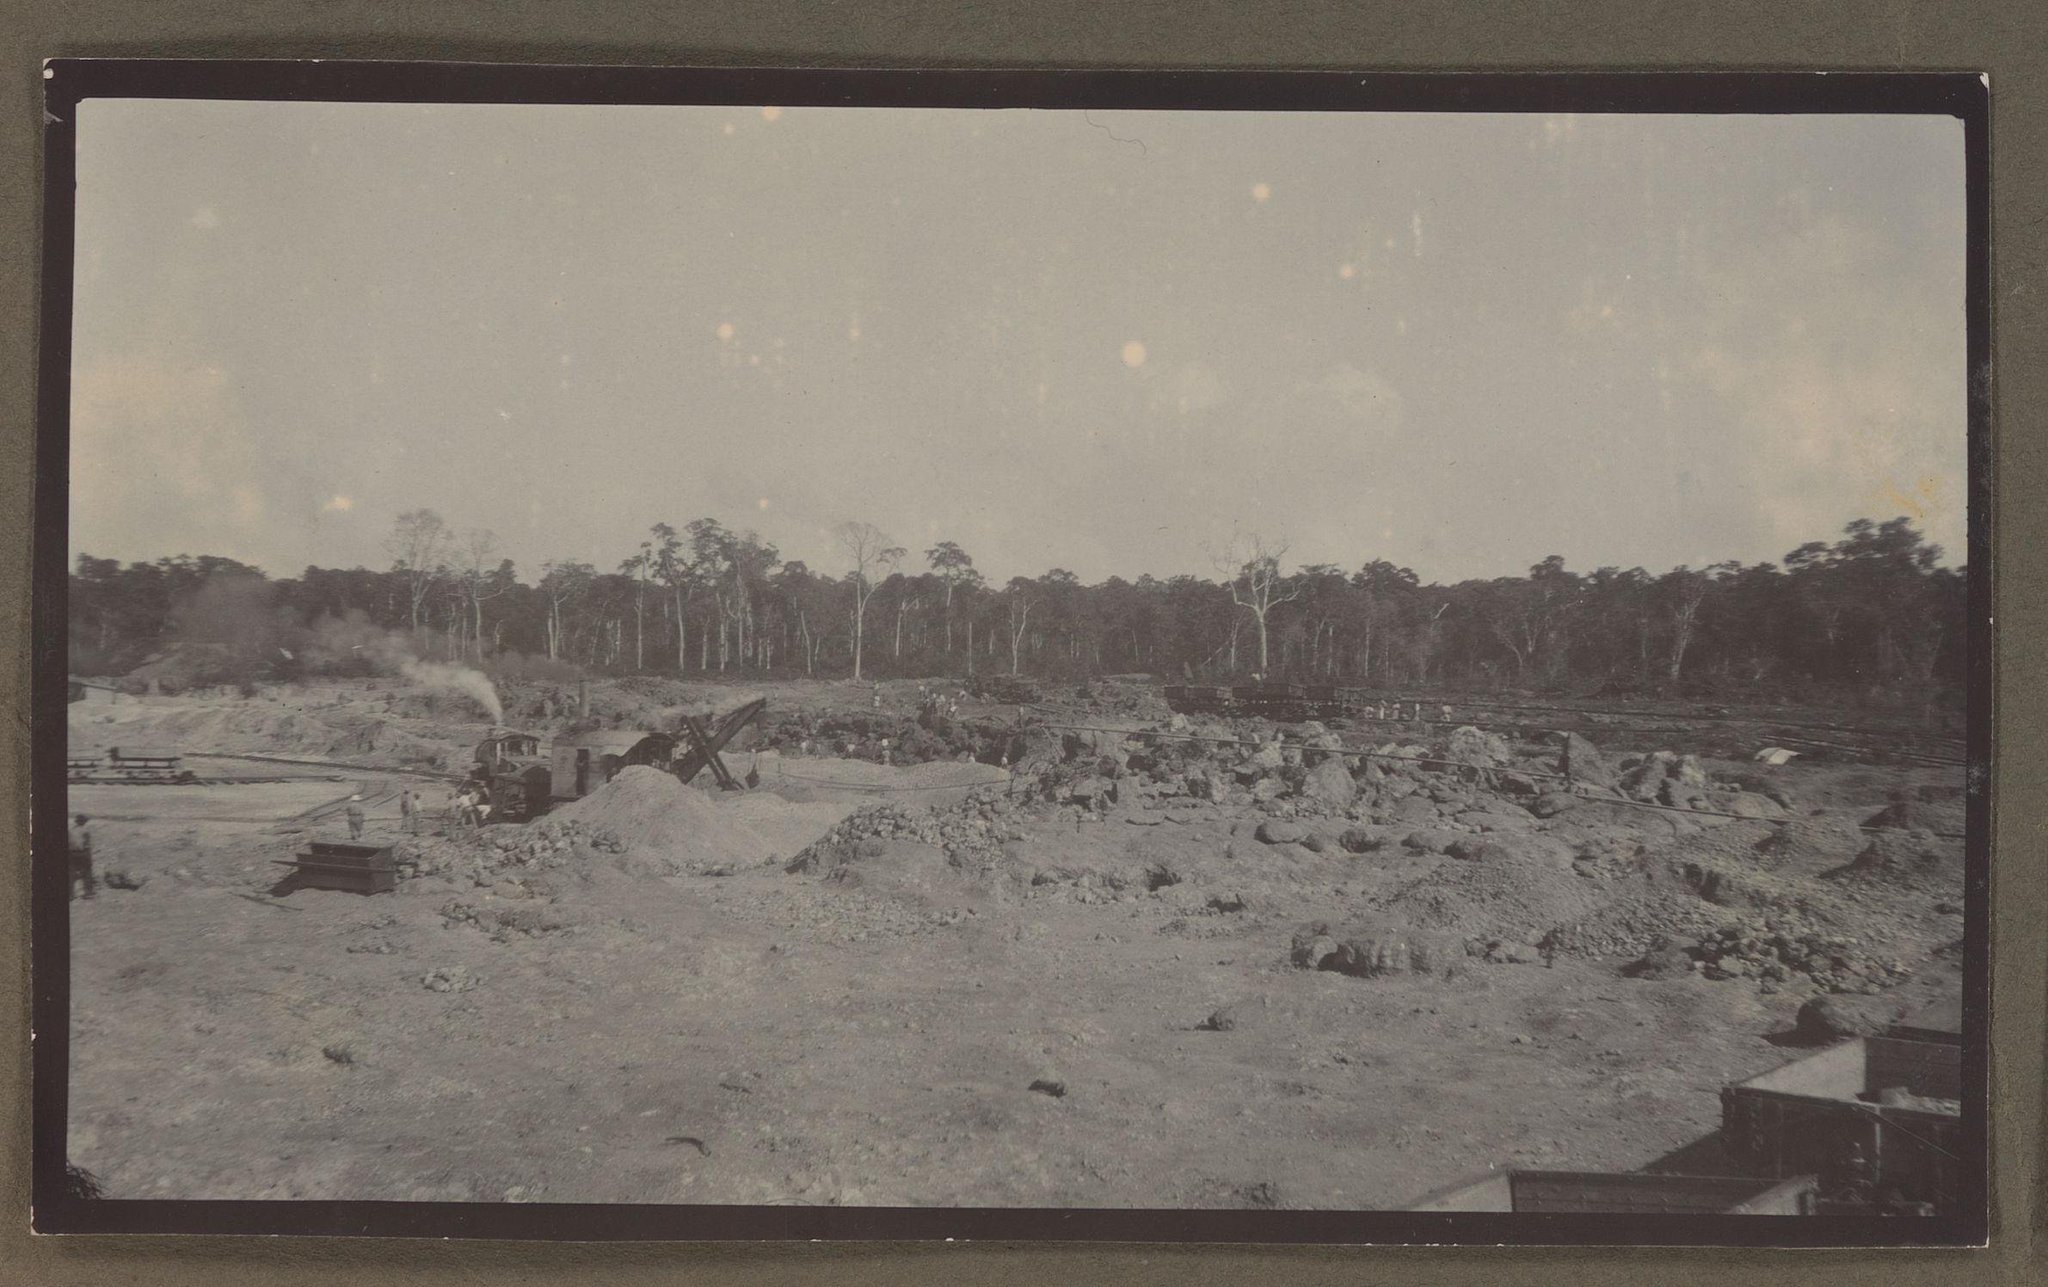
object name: photograph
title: Mijn en fabriek in Moengo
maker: Anonymous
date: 1925-1927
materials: photographic support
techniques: photography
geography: suriname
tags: jetten, familie, moengo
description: Terrein van de mijn en fabriek in Moengo. Foto op een bladzijde van een los albumblad. Onderdeel van het ensemble met foto's van de familie van ingenieur Jetten in de mijnbouwstad Moengo in Suriname.